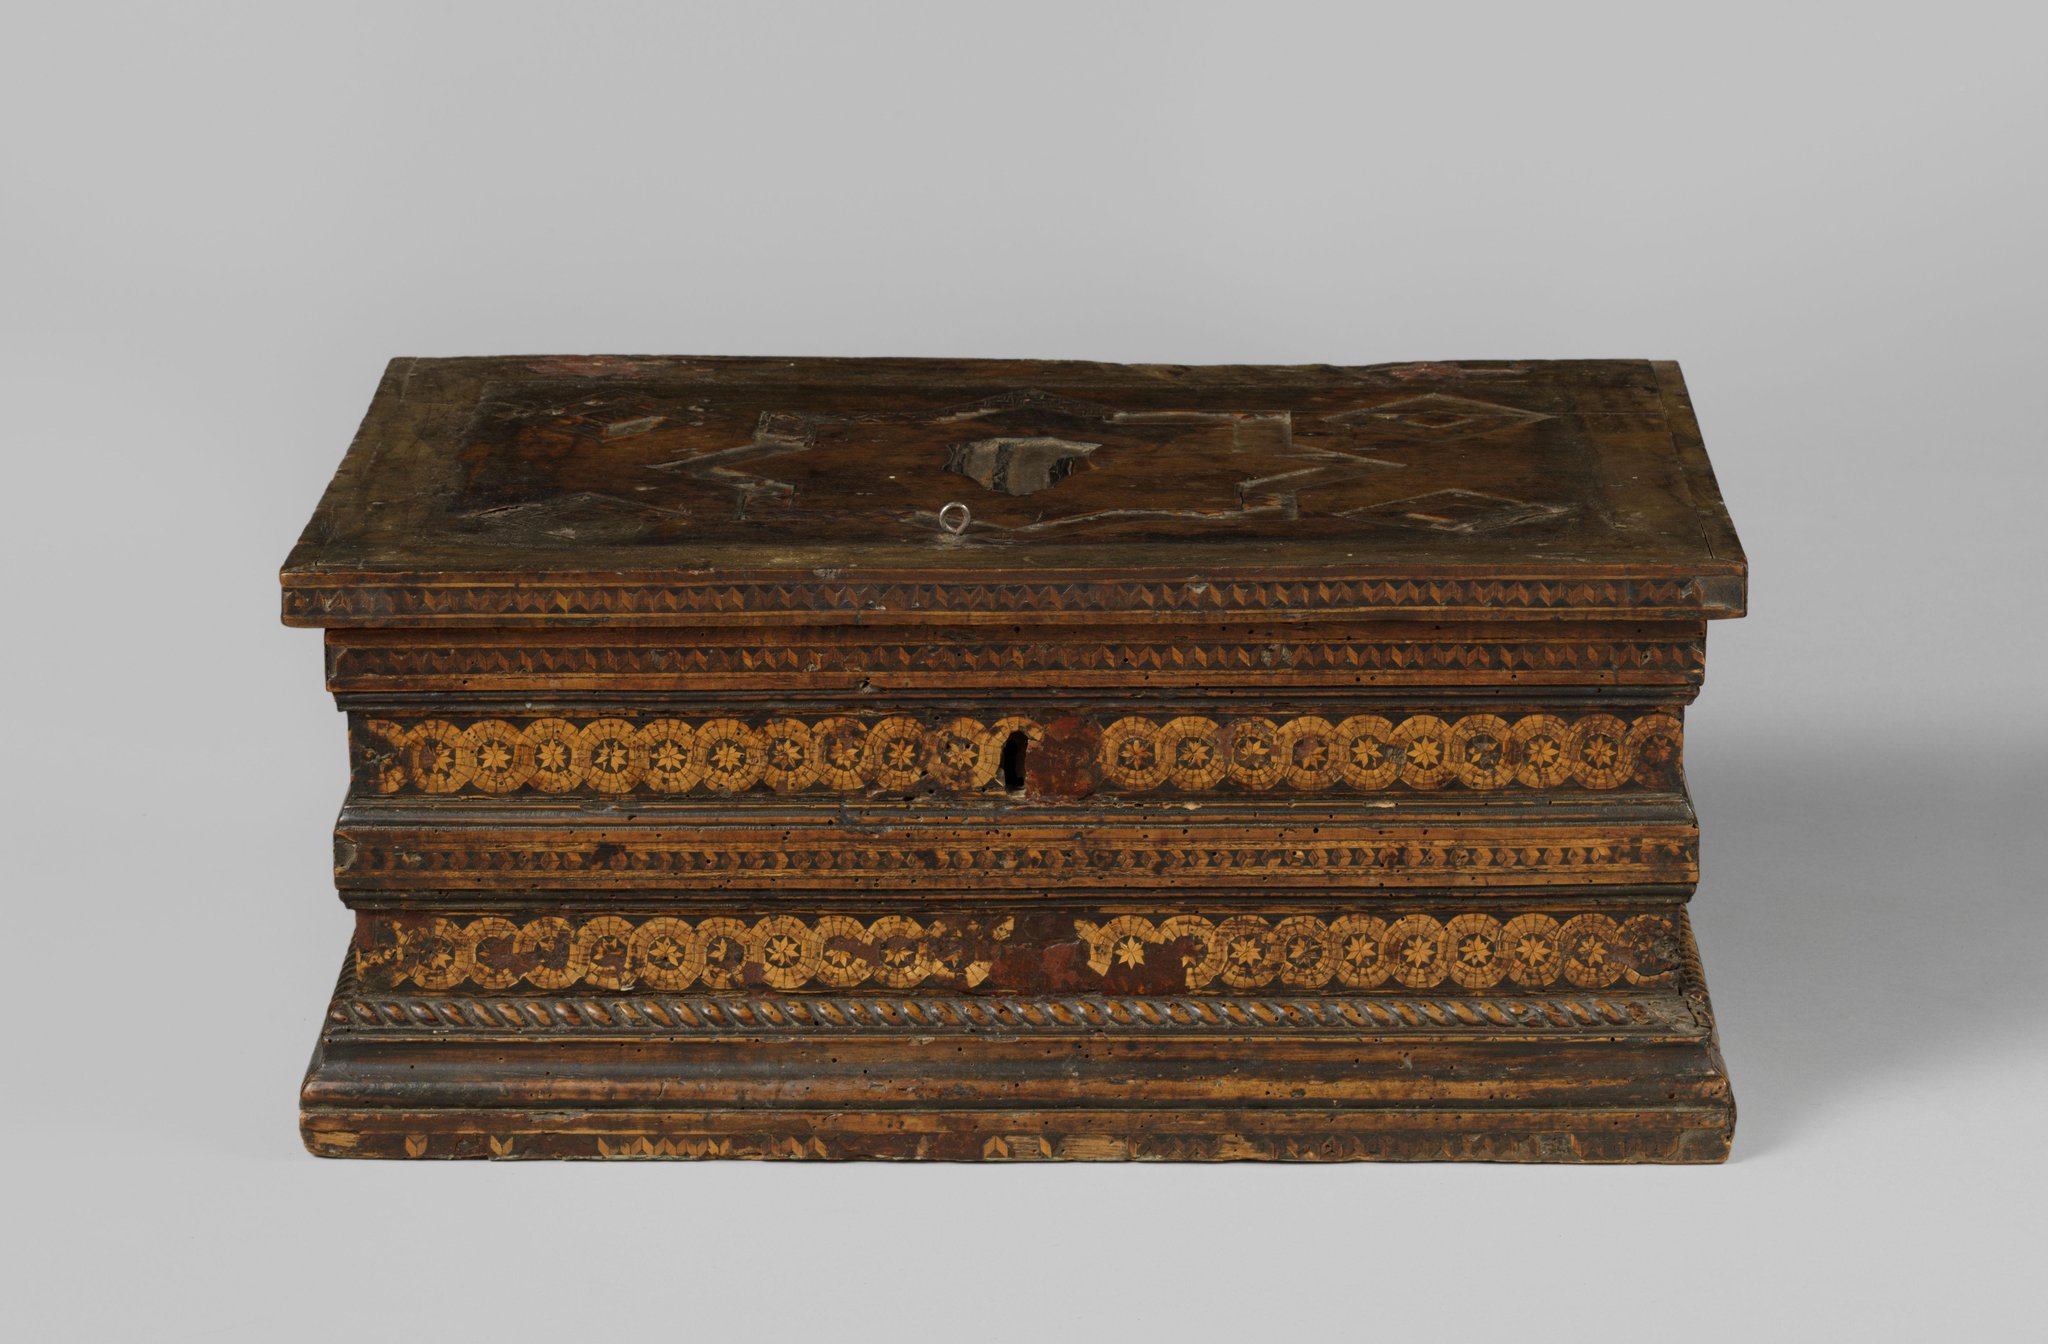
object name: chest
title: Schrijfkist versierd met intarsia in notenhout en andere houtsoorten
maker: Anonymous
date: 1500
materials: copper, wood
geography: italy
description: Writing box. Walnut, inlaid with various woods. Italy, c. 1500.